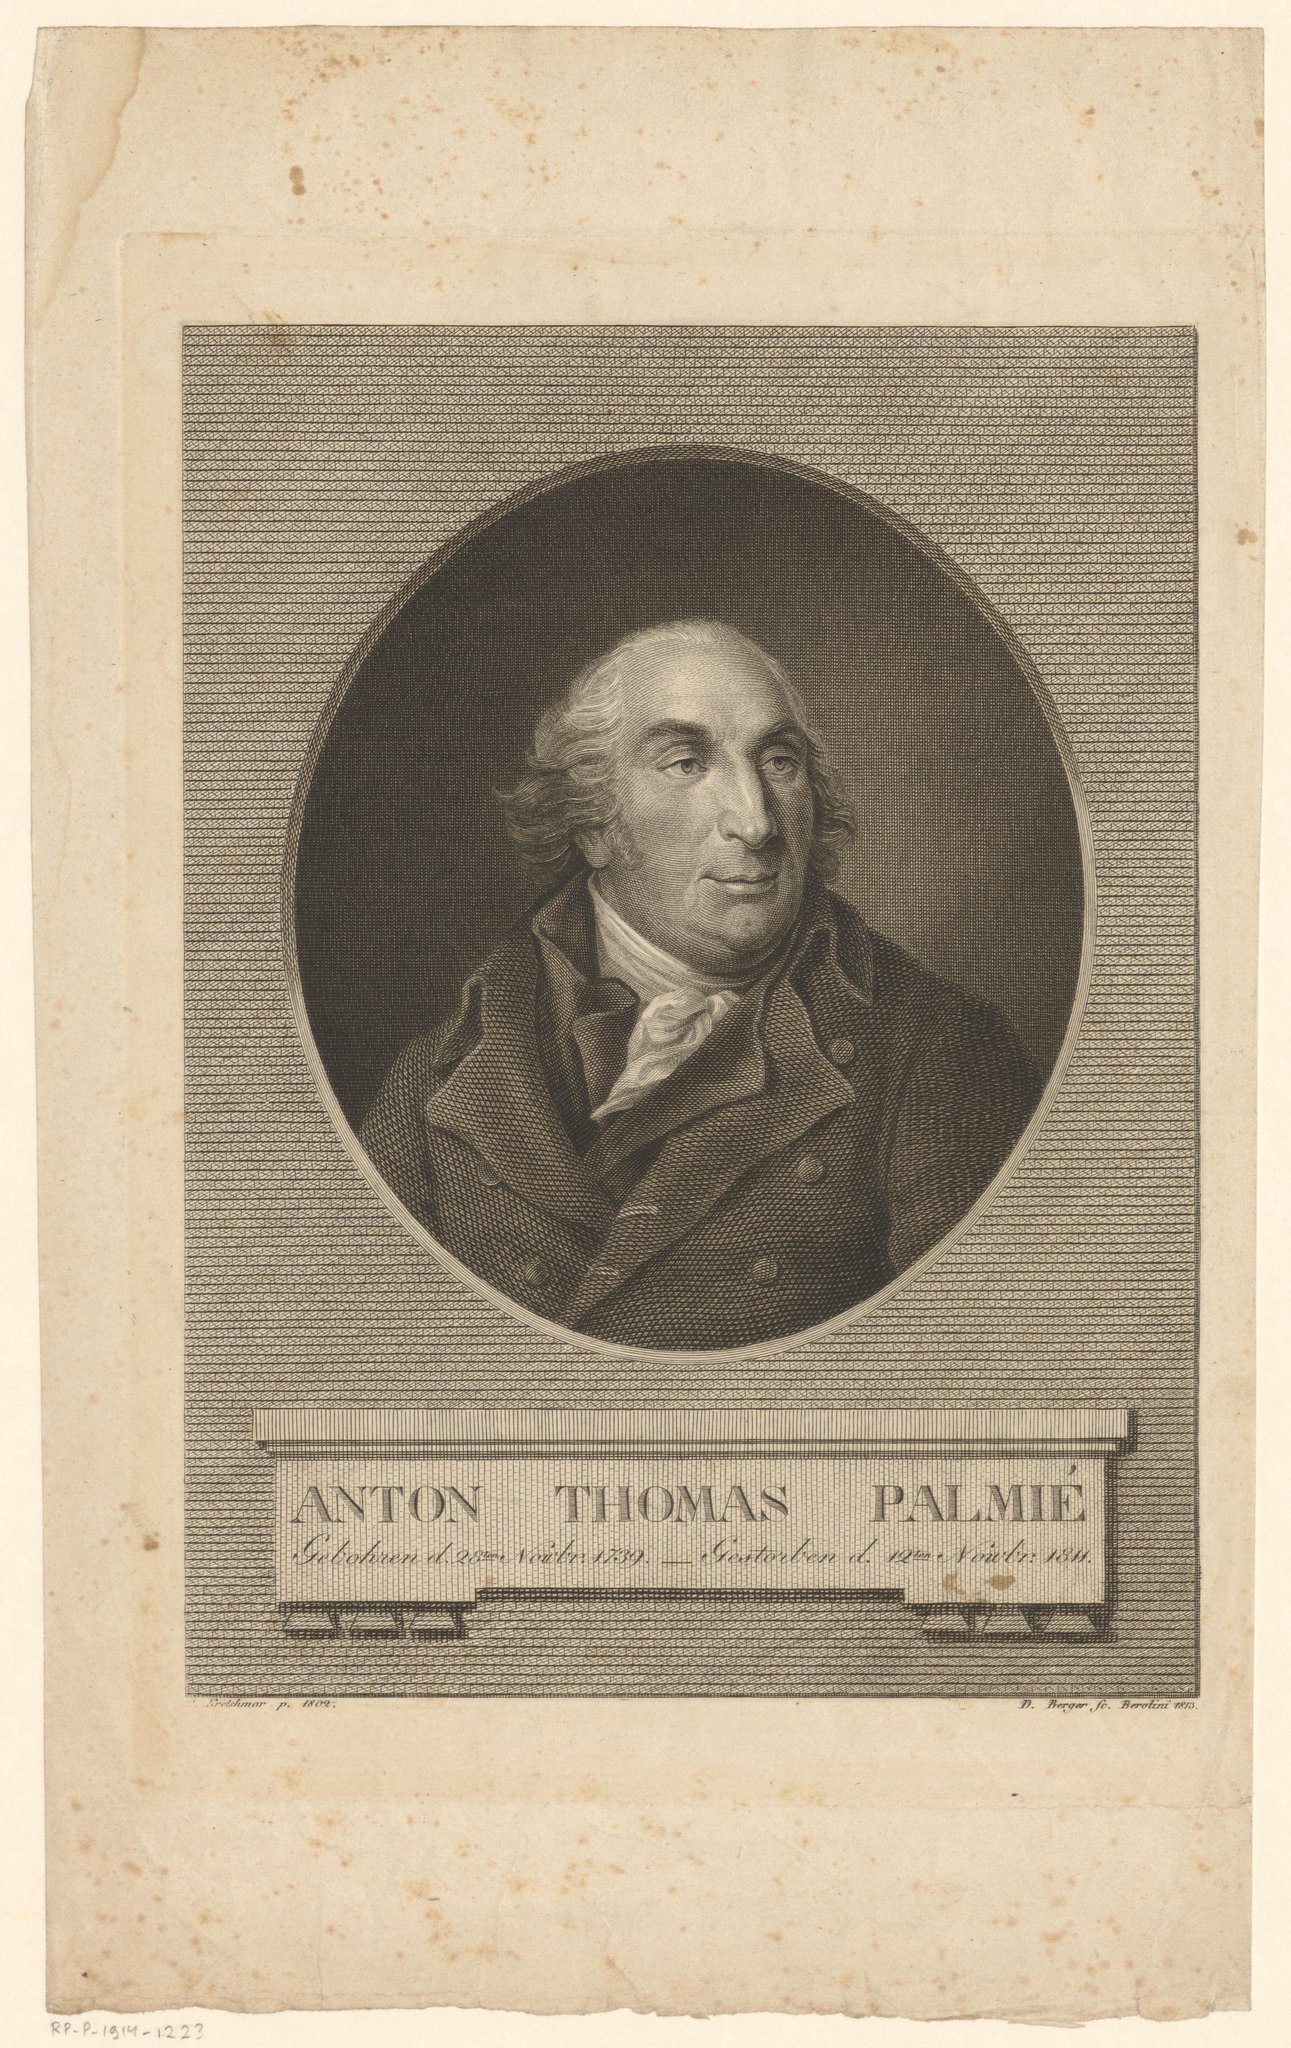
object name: print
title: Portret van Anton Thomas Palmié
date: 1813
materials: paper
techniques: engraving, etching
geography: berlin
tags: historical persons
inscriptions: collector's mark: Lugt 2228